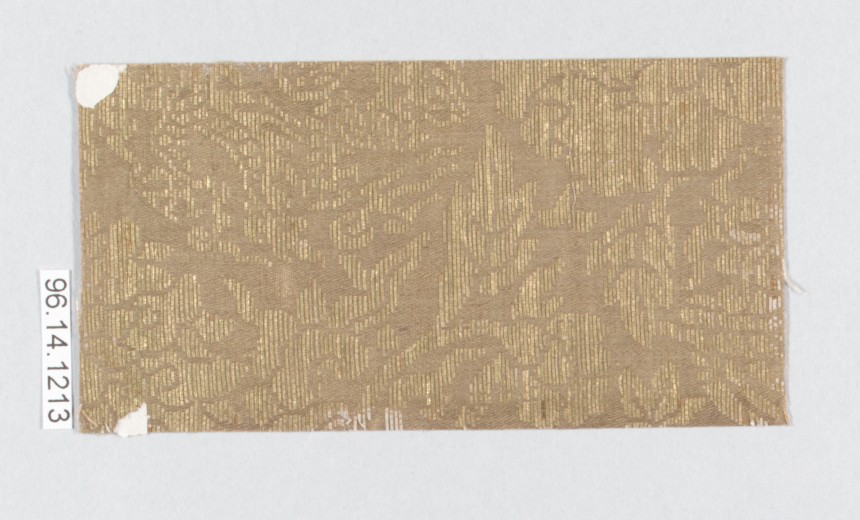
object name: piece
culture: japanese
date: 1701-1900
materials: silk